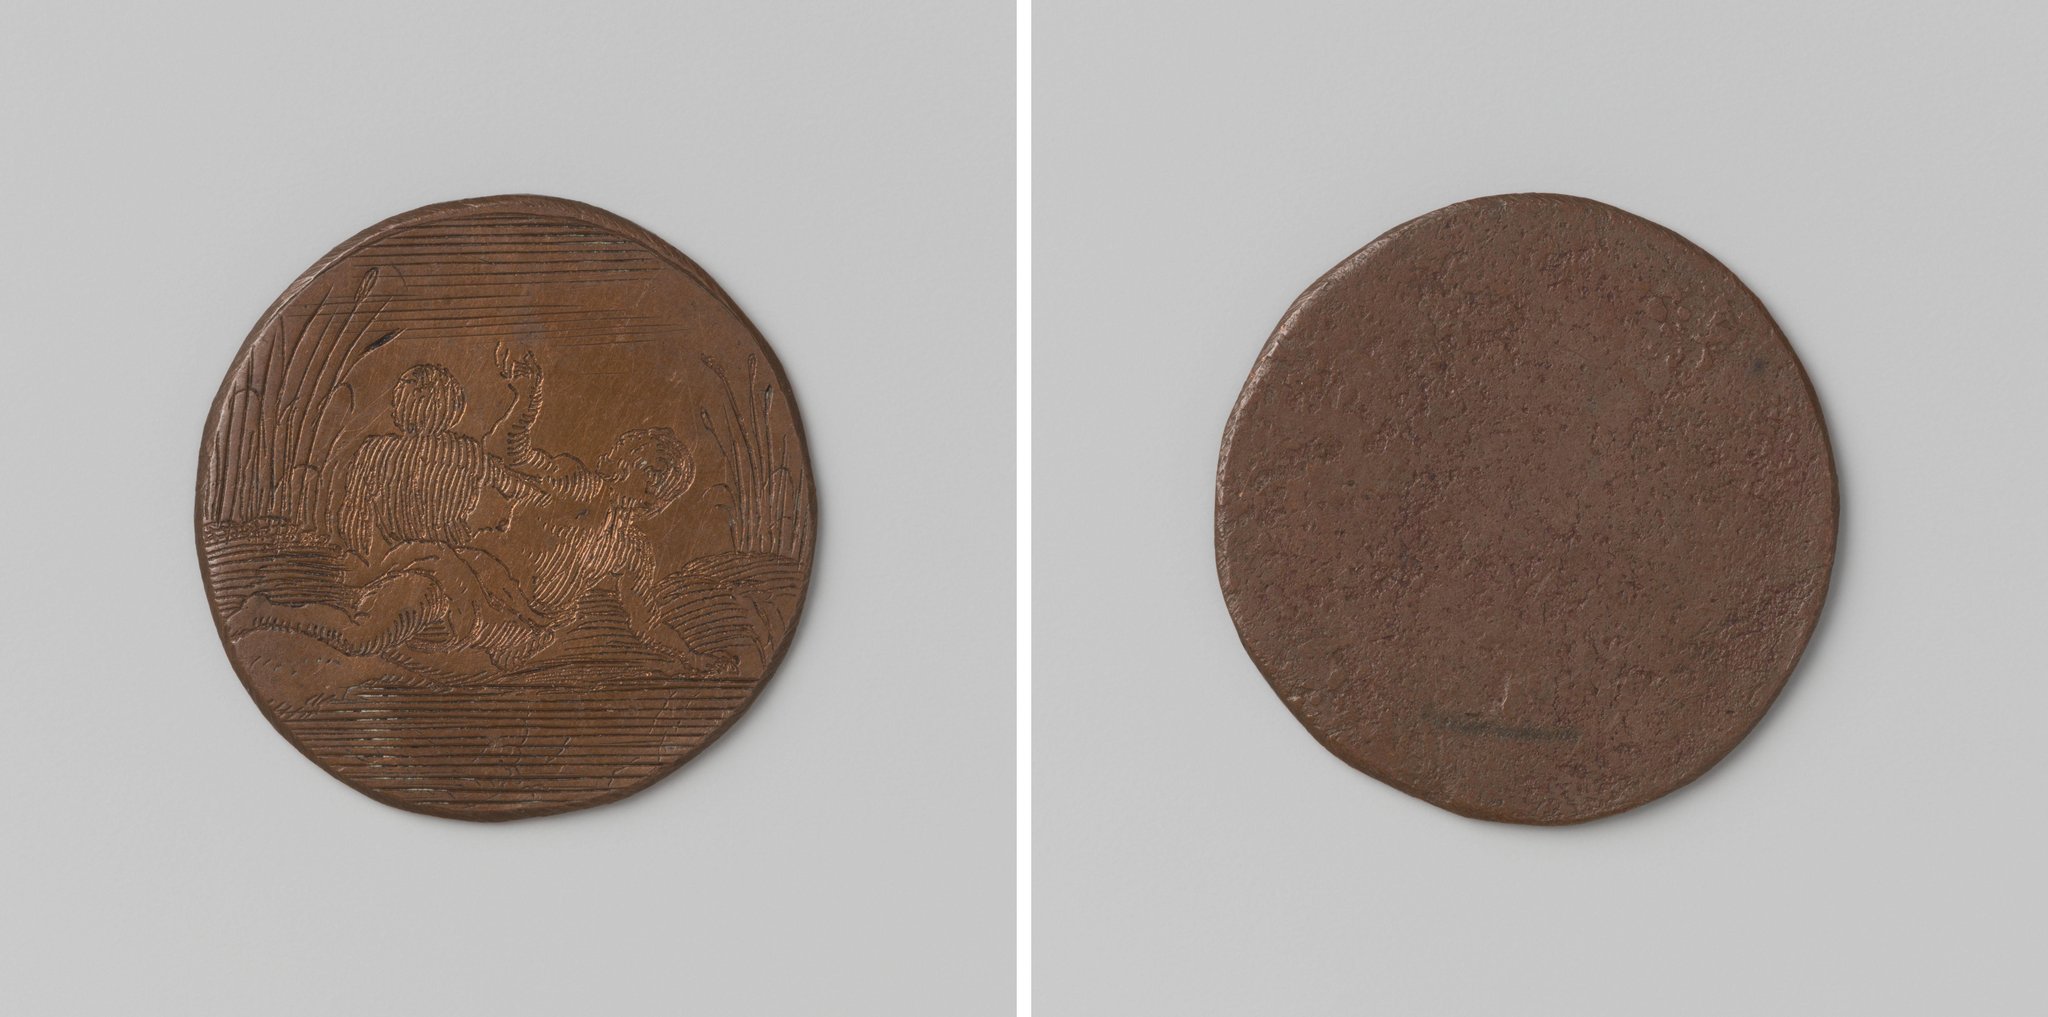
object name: medal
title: Man aan water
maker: Anonymous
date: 1600-1700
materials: copper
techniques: engraving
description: Eenzijdig gegraveerde koperen penning. Voorzijde: met boven zijn hoofd geheven rechterhand bekijkt een half liggende jongeman zich in het water; achter hem een silhouet. Keerzijde: blanco.